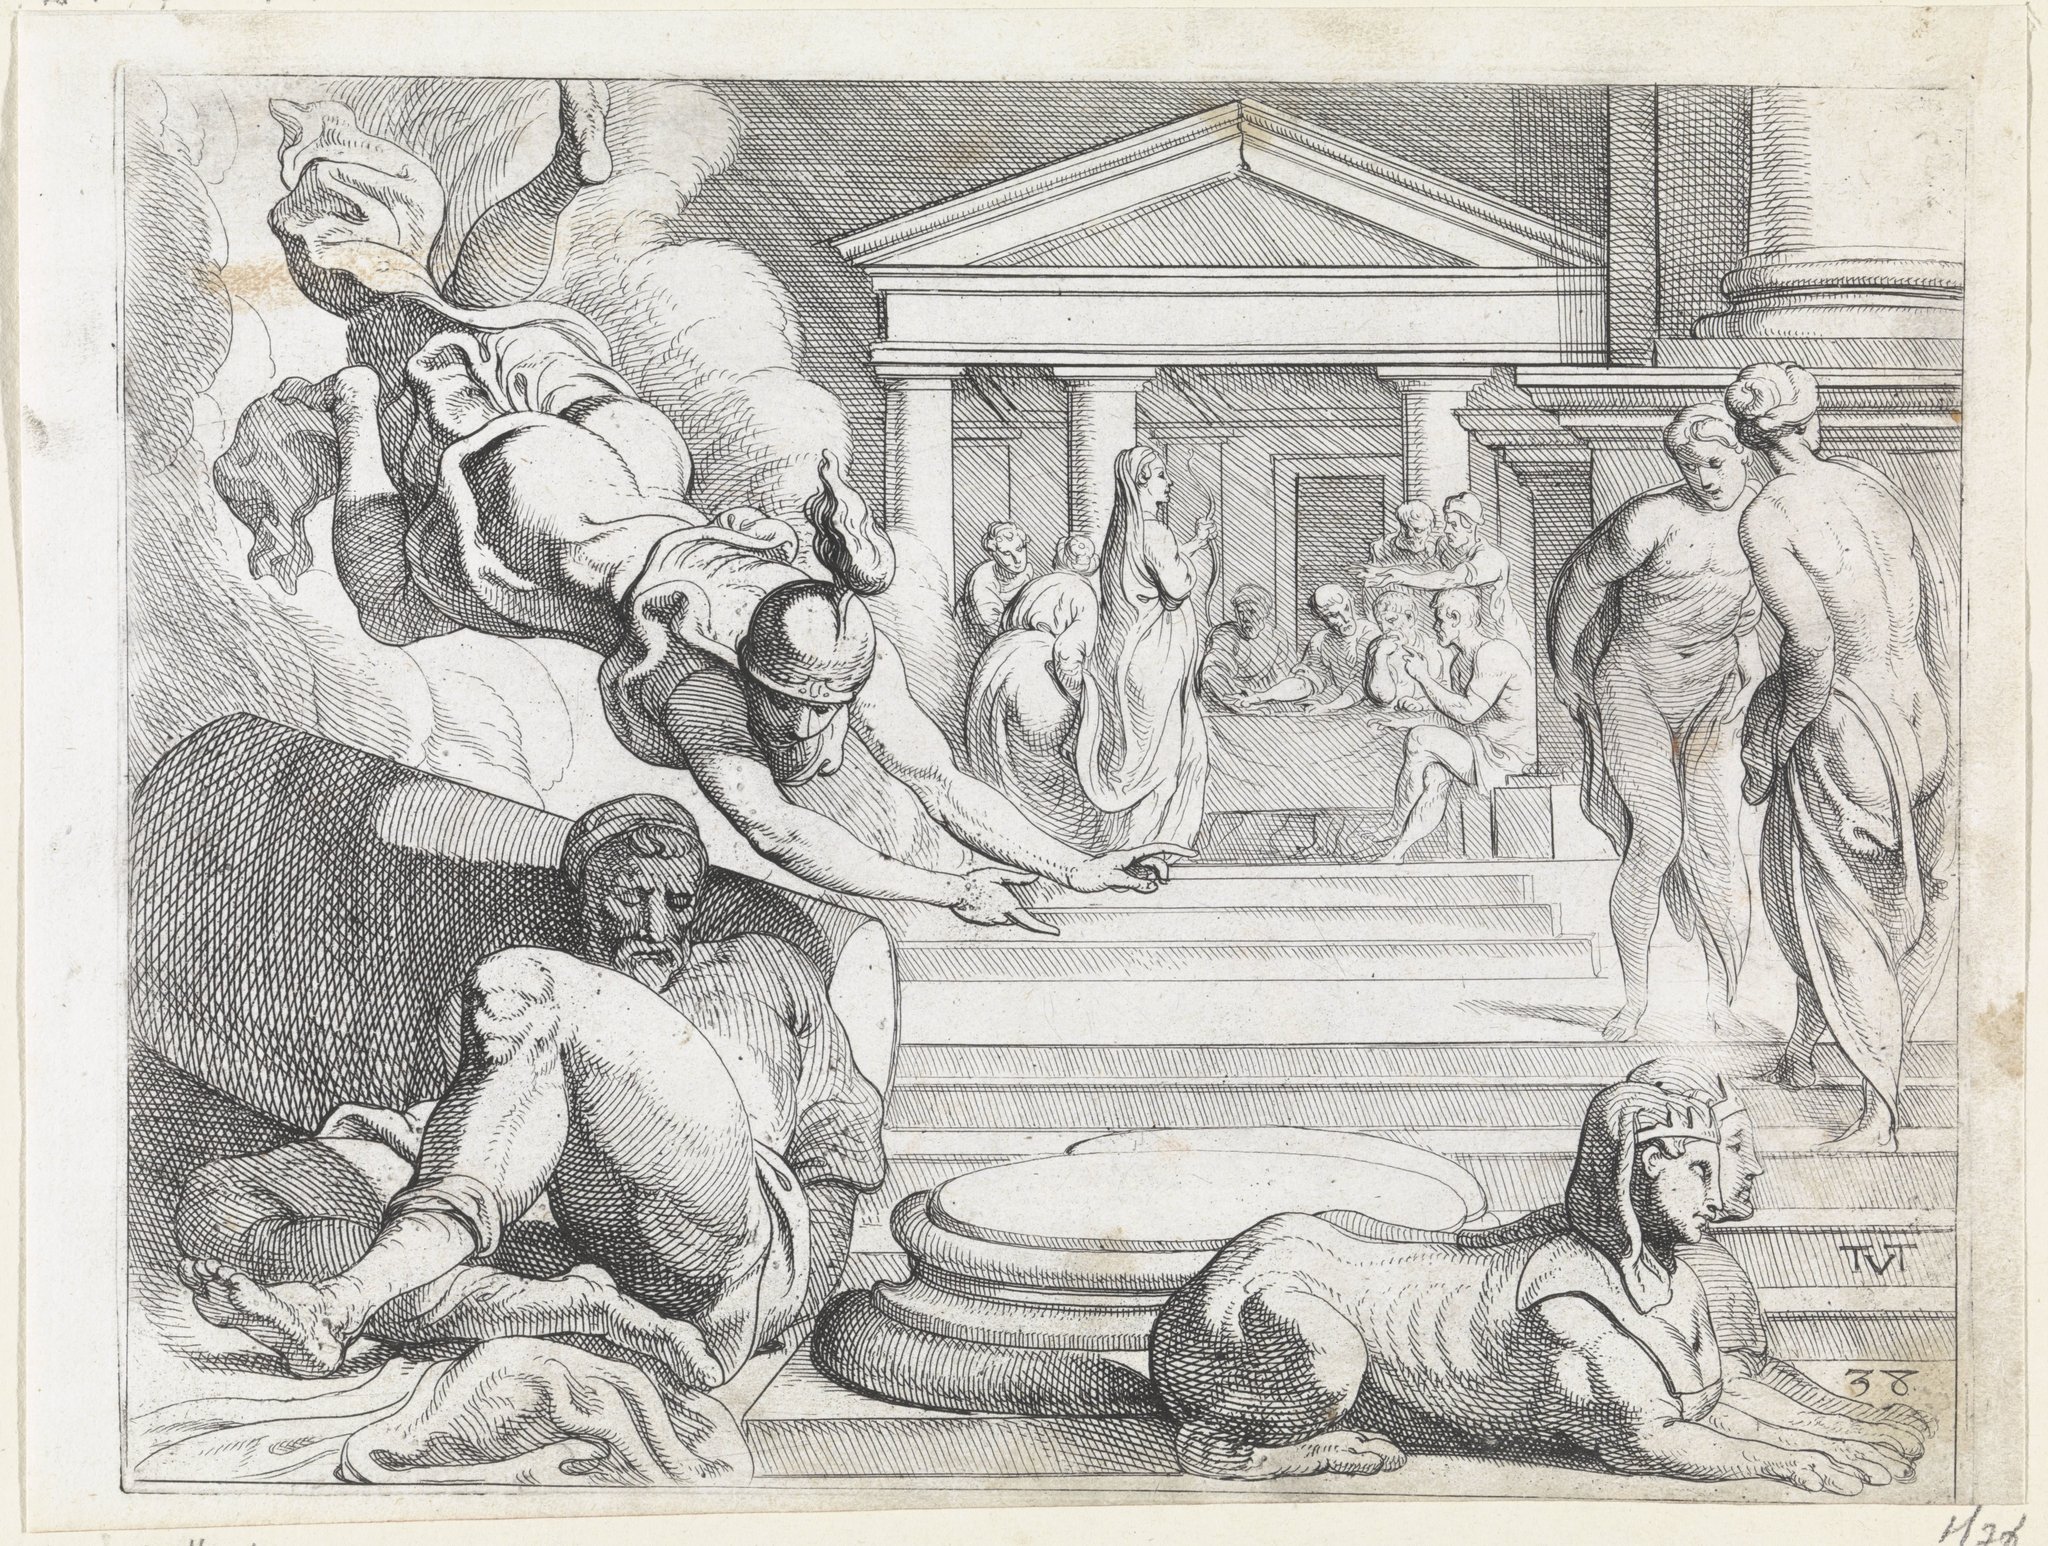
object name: print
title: Minerva zet Odysseus aan om de boog te vragen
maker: theodoor van thulden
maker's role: draughtsman, painter, print maker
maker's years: 1606-1669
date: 1632-1633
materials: paper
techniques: engraving, etching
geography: paris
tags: penelope announces she will marry the man who can shoot an arrow through twelve axe-rings, and produces ulysses' bow (homer, odyssey xxi)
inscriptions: collector's mark: Lugt 2228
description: Minerva bezoekt de slapende Odysseus en zet hem ertoe aan naar het paleis te gaan en de boog te spannen. Op de achtergrond toont Penelope de boog van Odysseus aan haar vrijers en deelt daarbij mee dat ze zal trouwen met degene die de boog kan spannen.